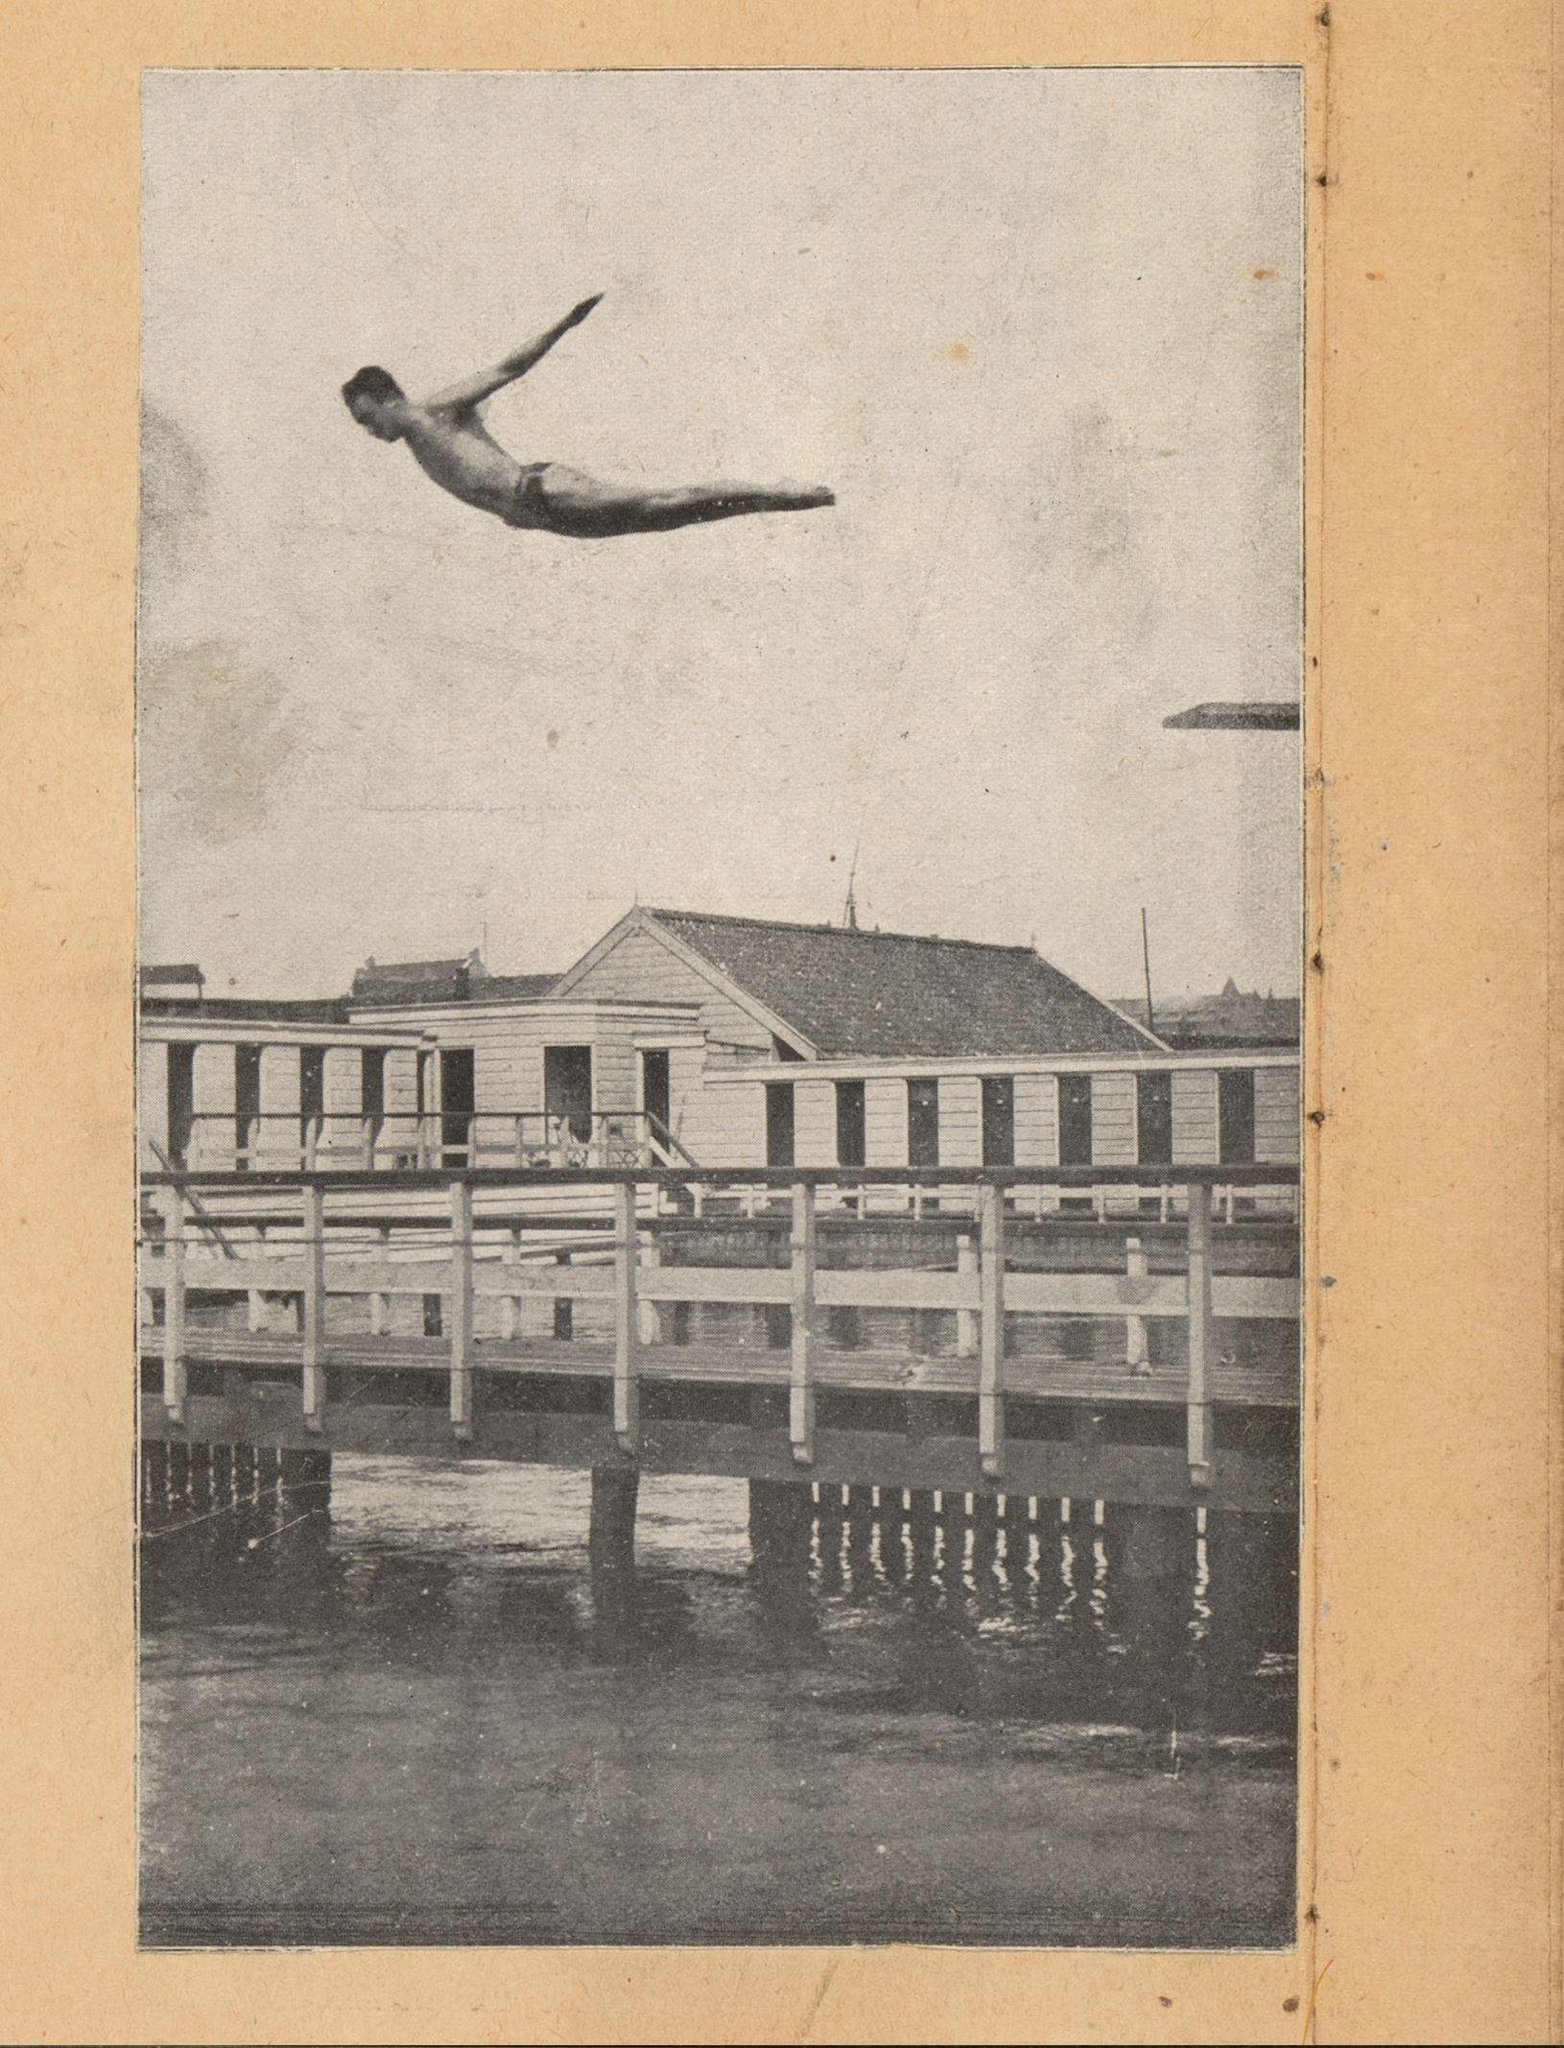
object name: photograph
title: Man maakt zweefduik in zwembad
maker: Anonymous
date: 1900-1920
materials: paper, ink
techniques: autotype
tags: diving (movement in water), swimming (sport)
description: Onderdeel van Familiealbum met foto's van een familie in de voormalige kolonie Nederlands-Indië en van een suikerfabriek in Purworejo.